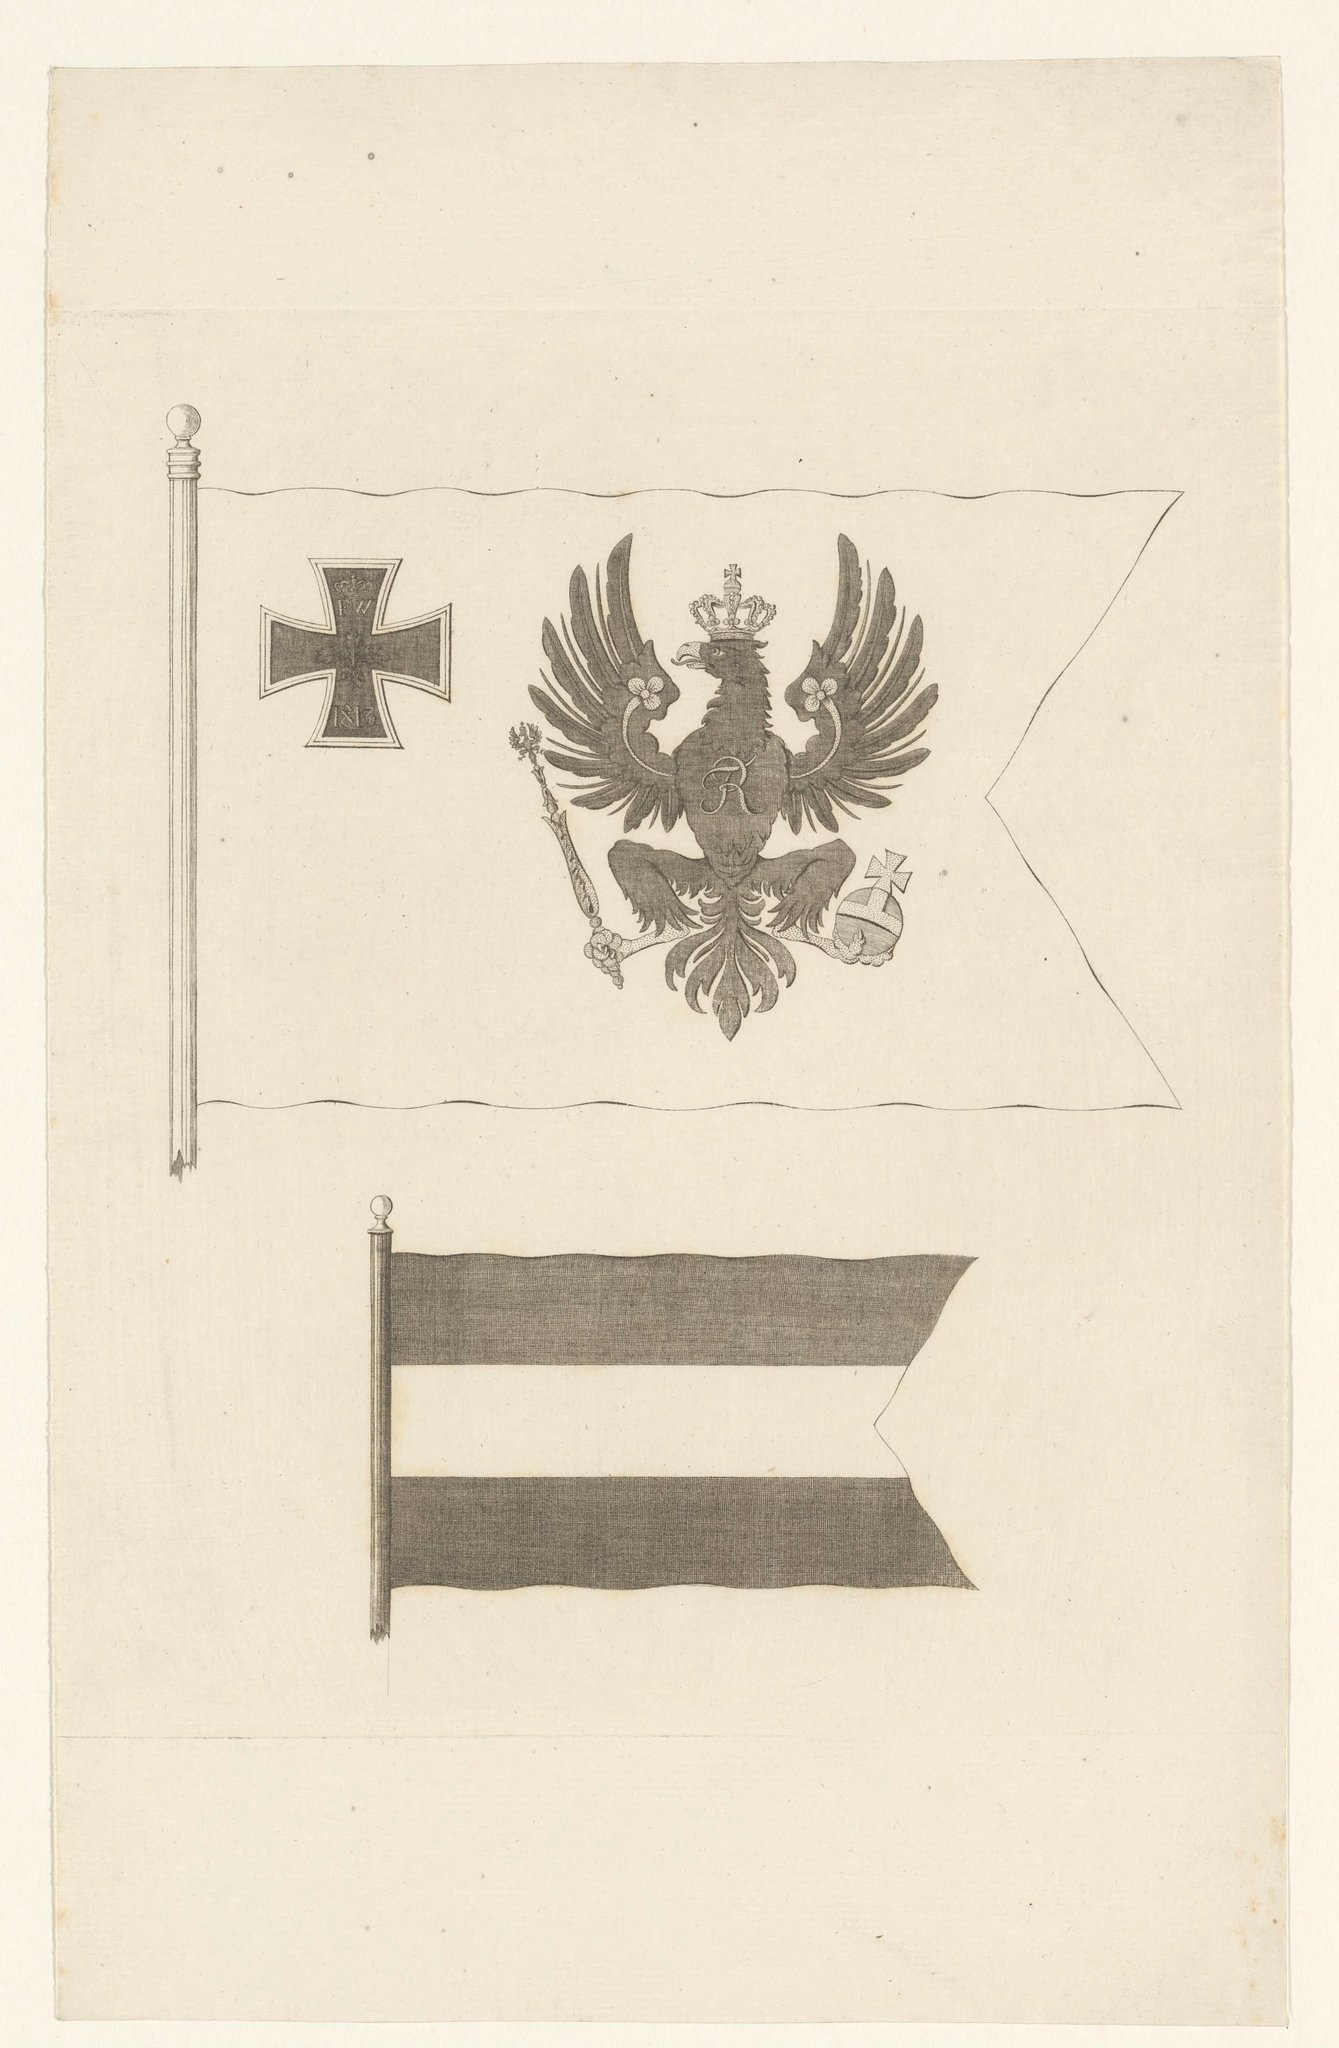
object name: print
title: Twee vlaggen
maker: Anonymous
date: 1813-1850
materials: paper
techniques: etching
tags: (military) flags and standards, flag, colours (as symbol of the state, etc.)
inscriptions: collector's mark: Lugt 2228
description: Twee vlaggen. Boven de vlag met de adelaar van het koninkrijk Pruisen en een kruis gemerkt FW 1813. Onder een vlag met drie horizontale banen in verschillende kleuren.